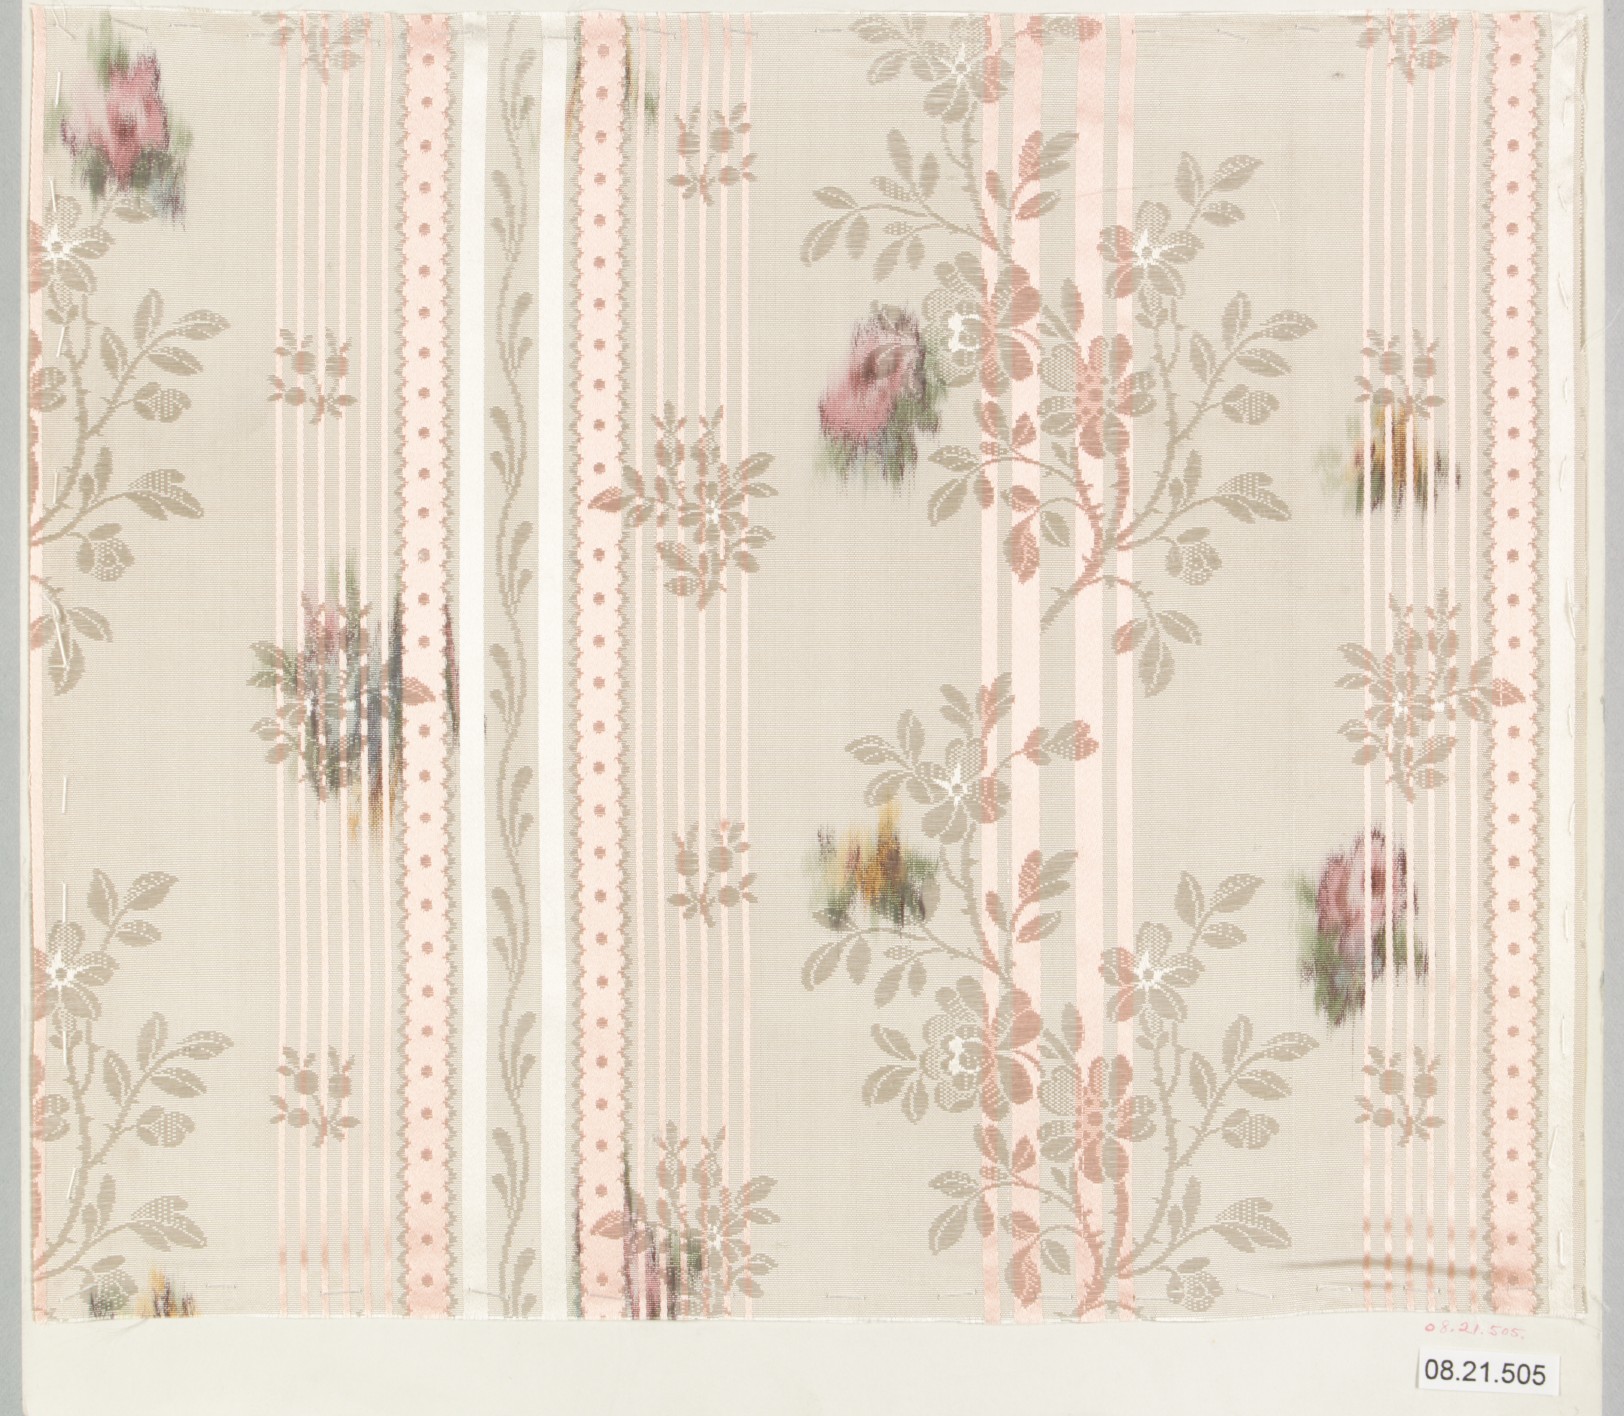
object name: textile sample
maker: Anonymous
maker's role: designer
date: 1900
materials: silk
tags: flowers,leaves